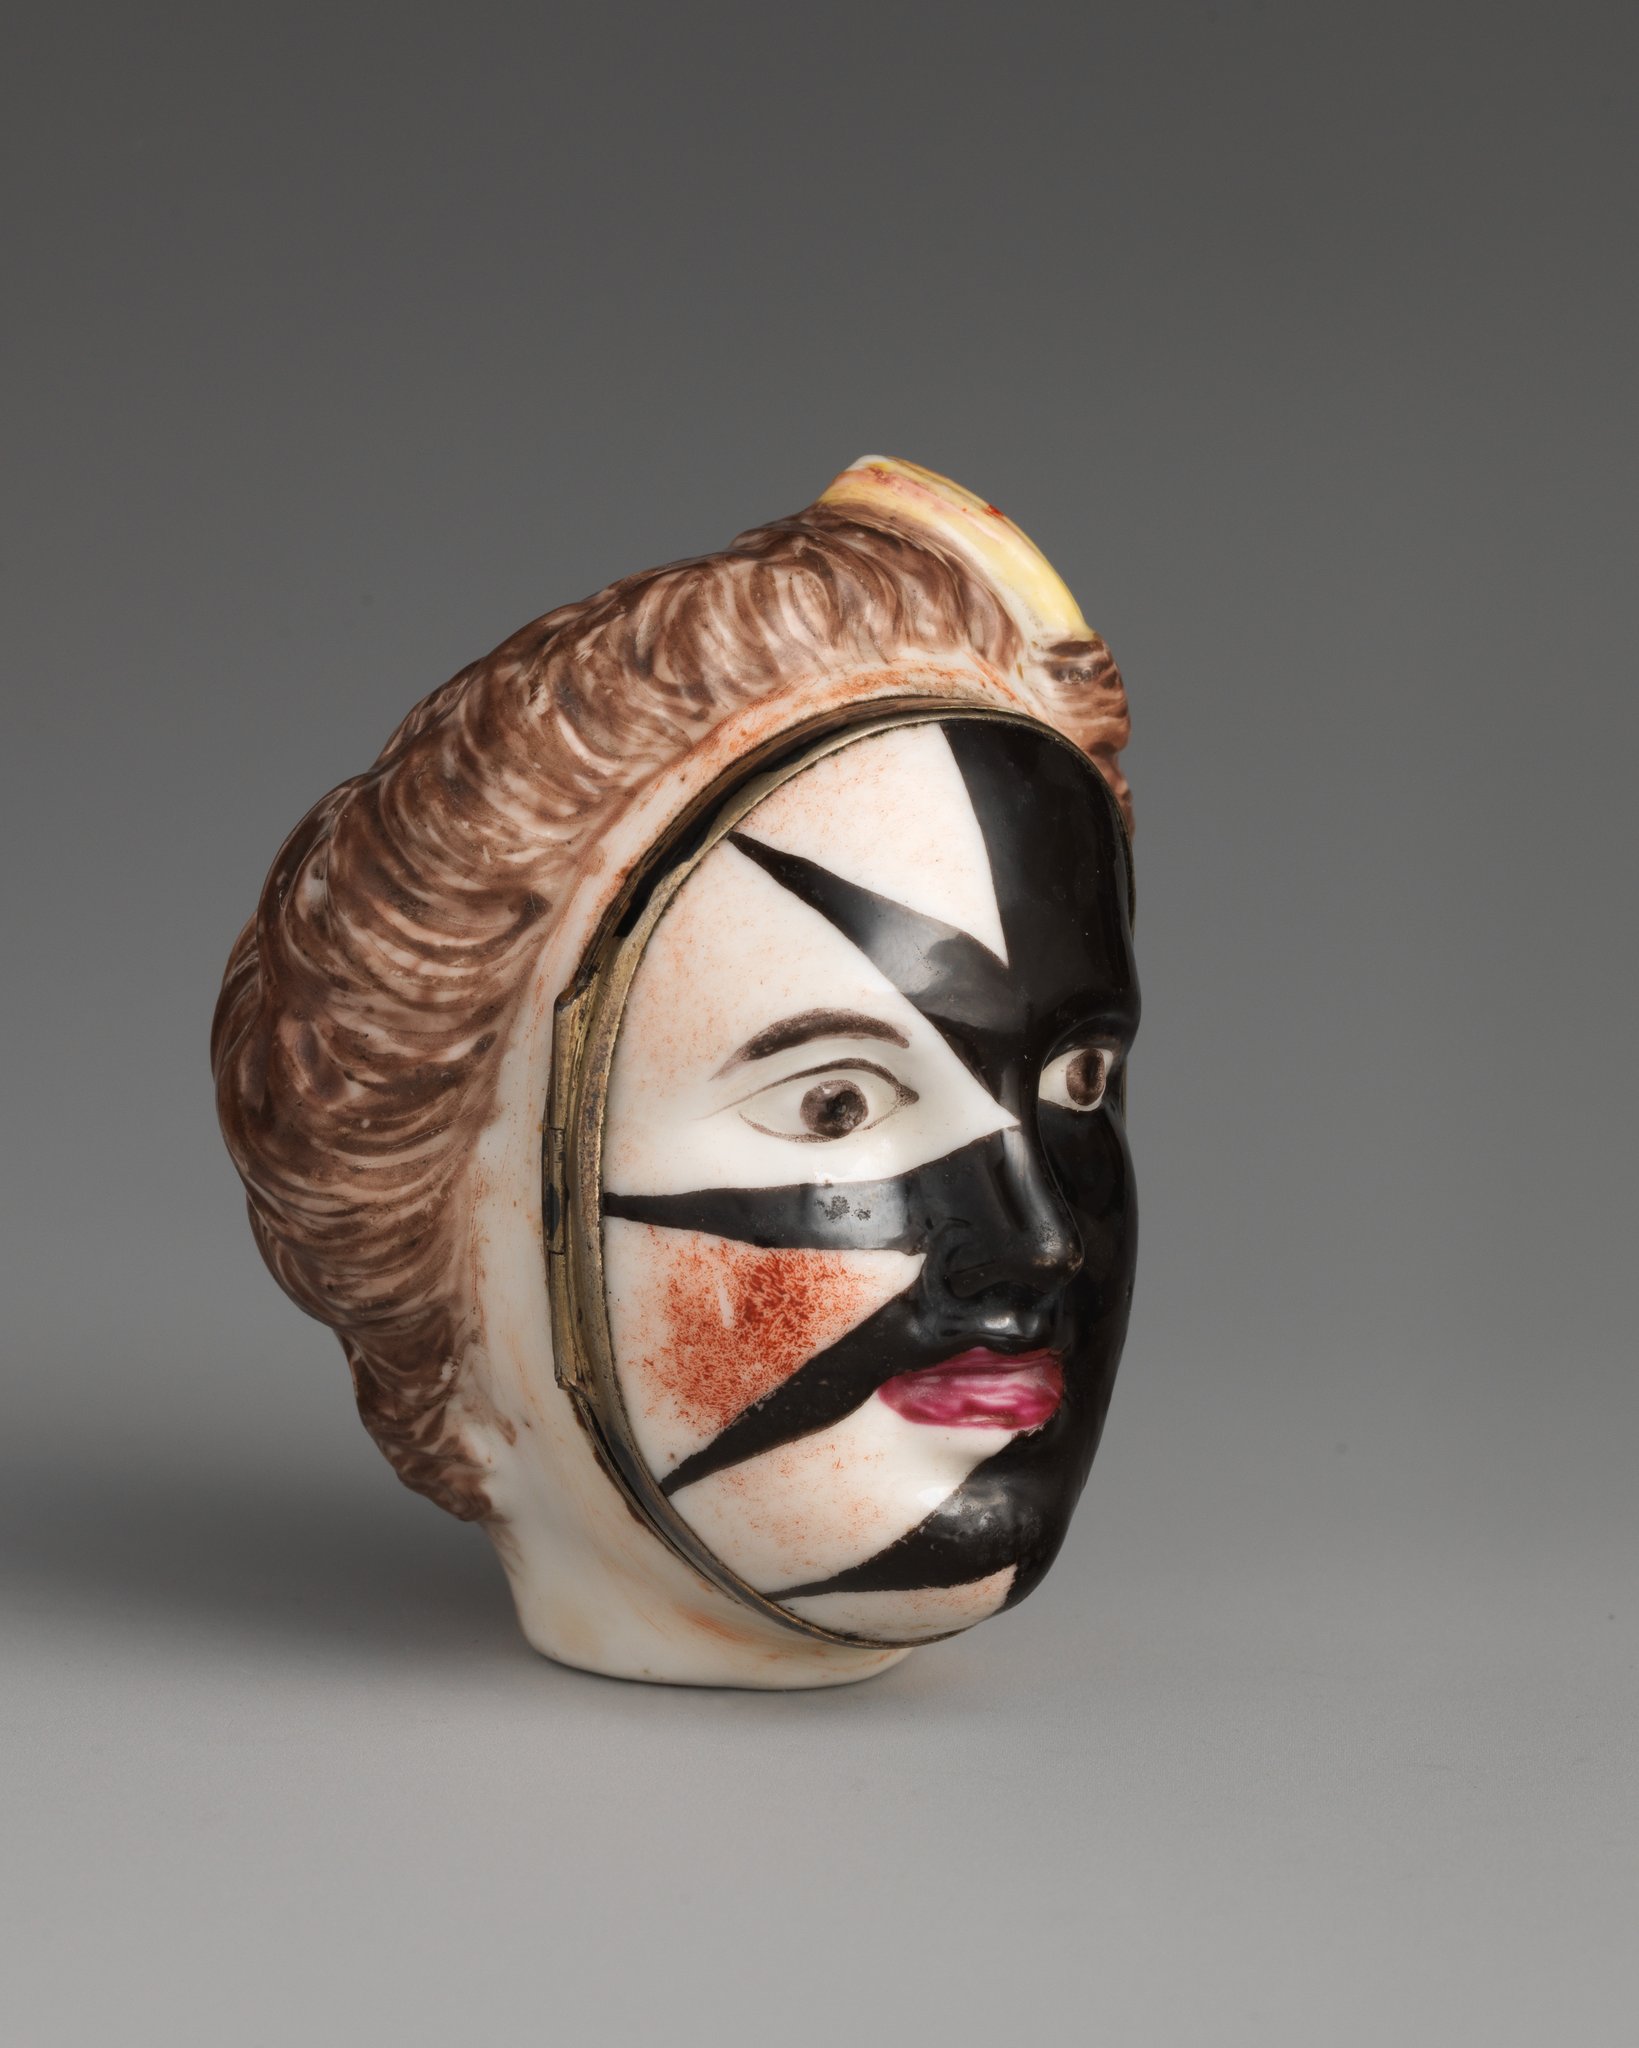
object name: toy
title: Lady's head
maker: mennecy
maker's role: factory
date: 1750-1755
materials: soft paste porcelain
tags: faces,heads,women